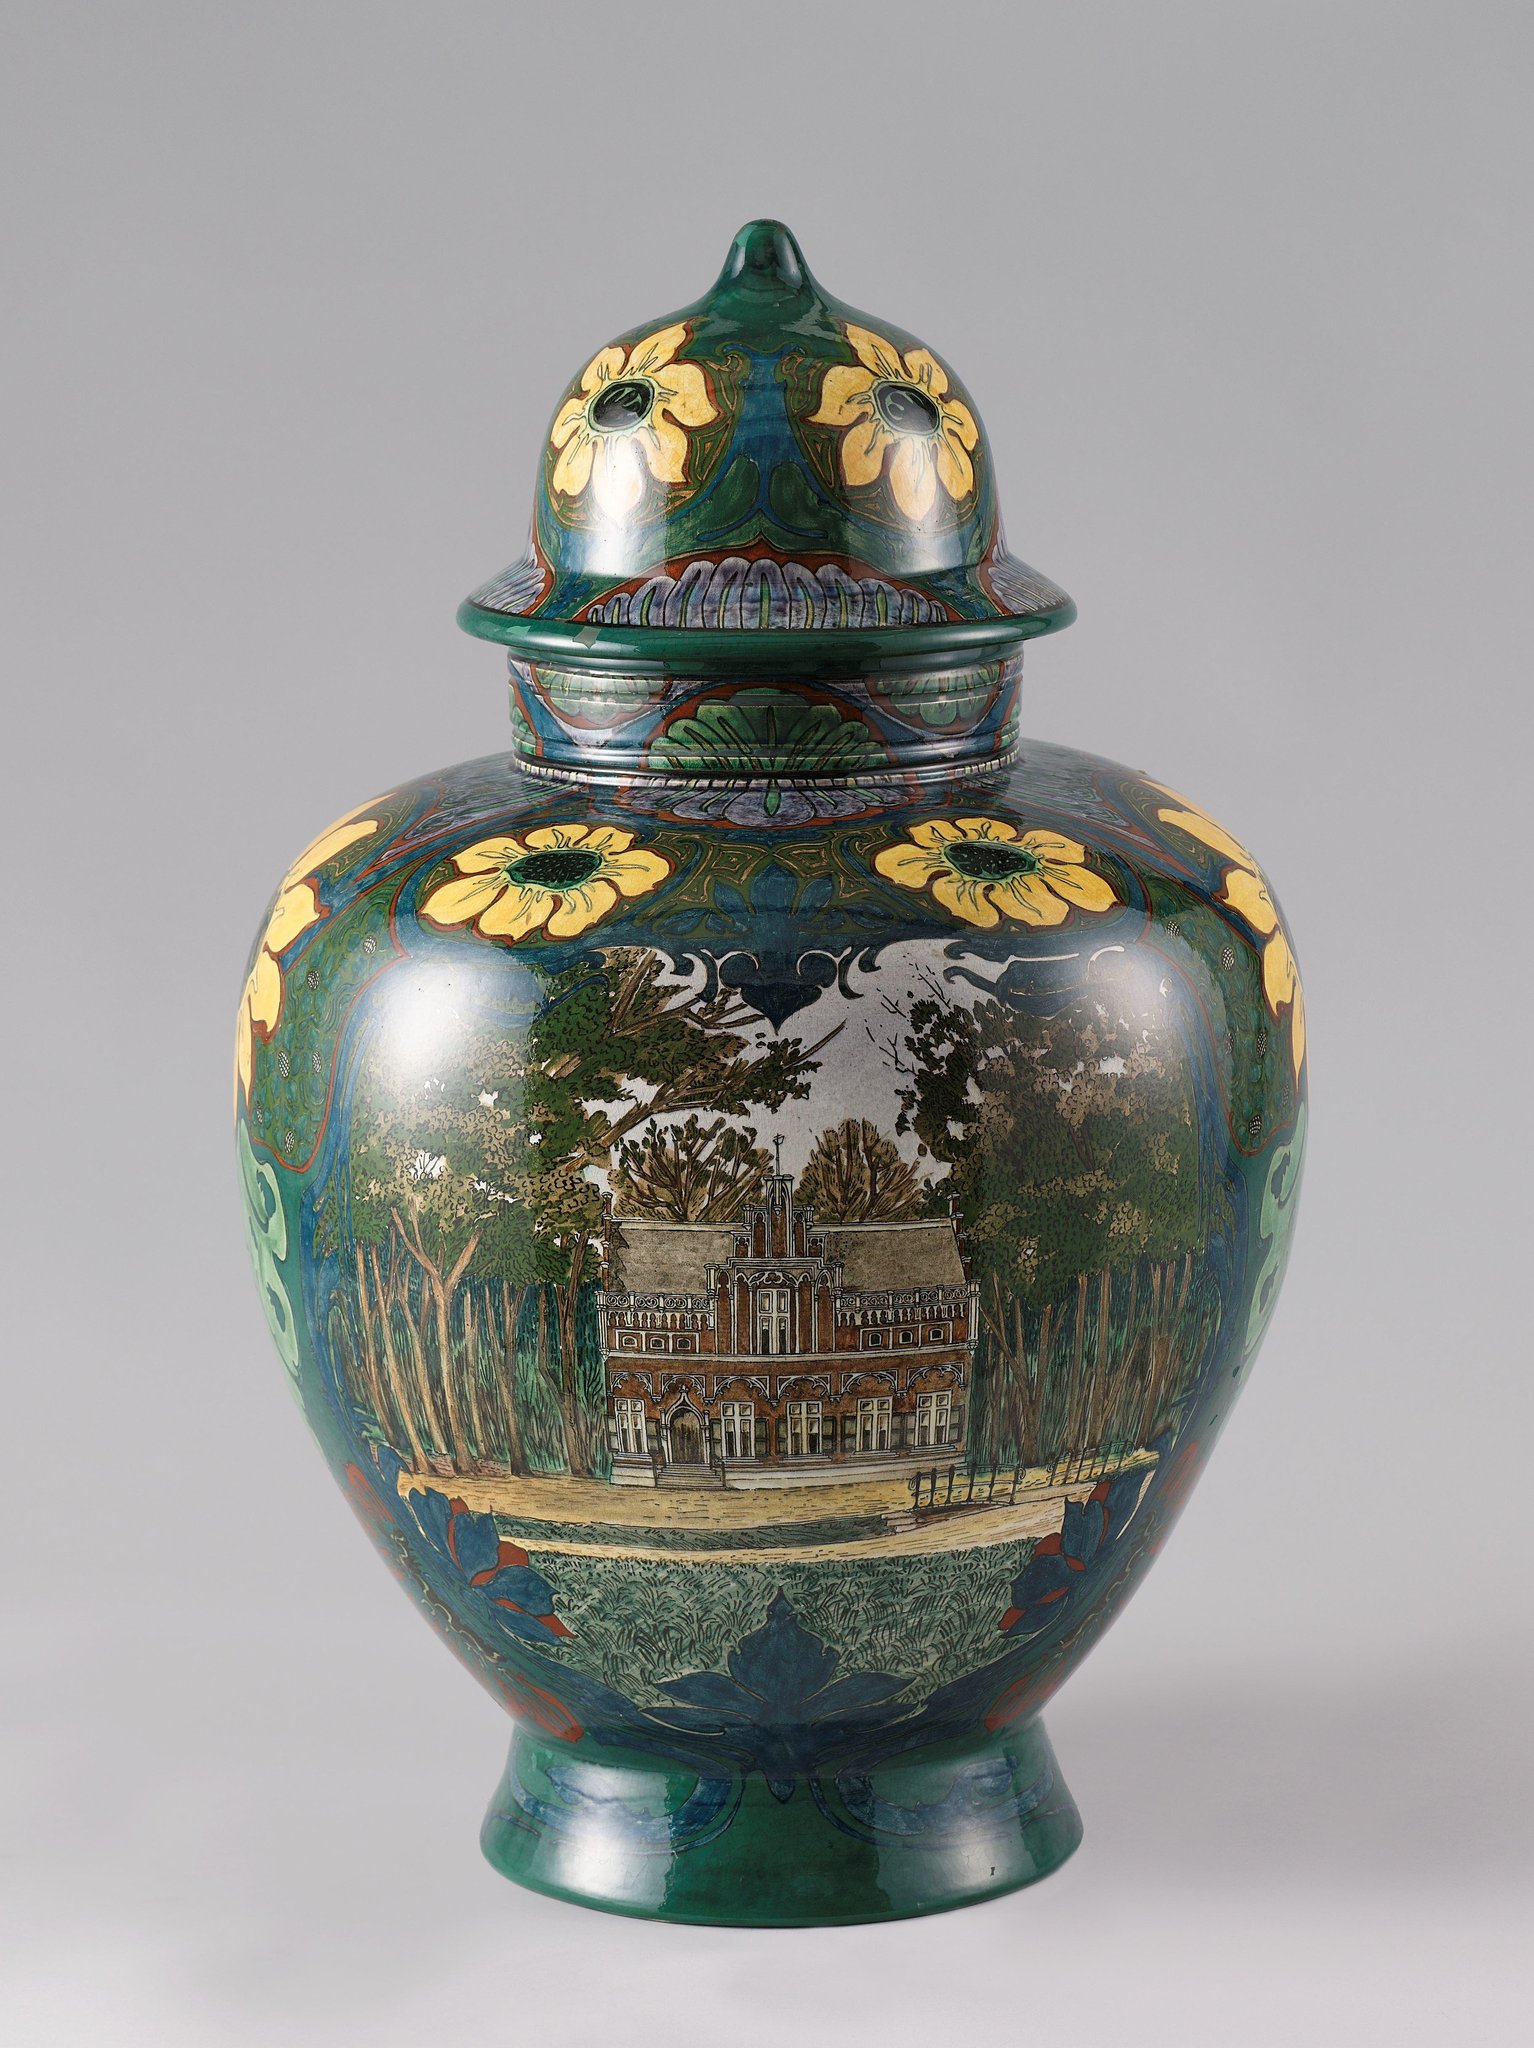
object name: lid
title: Deksel van vaas met het huis Ter Horst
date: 1896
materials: earthenware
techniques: painted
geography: the hague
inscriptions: mark: ‘Rozenburg // ooievaar // Den Haag ; NK (aaneen) x 473 ; LW110 (ingegrift)’, mark: ‘Rozenburg // ooievaar // Den Haag ; NK (aaneen) x 473 ; LW110 (ingegrift)’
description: Deksel van vaas van aardewerk, behorend bij een stel van drie, polychroom beschilderd met zonnebloemen en topografische voorstellingen. Op de deksel zijn vier zonnebloemen geschilderd.